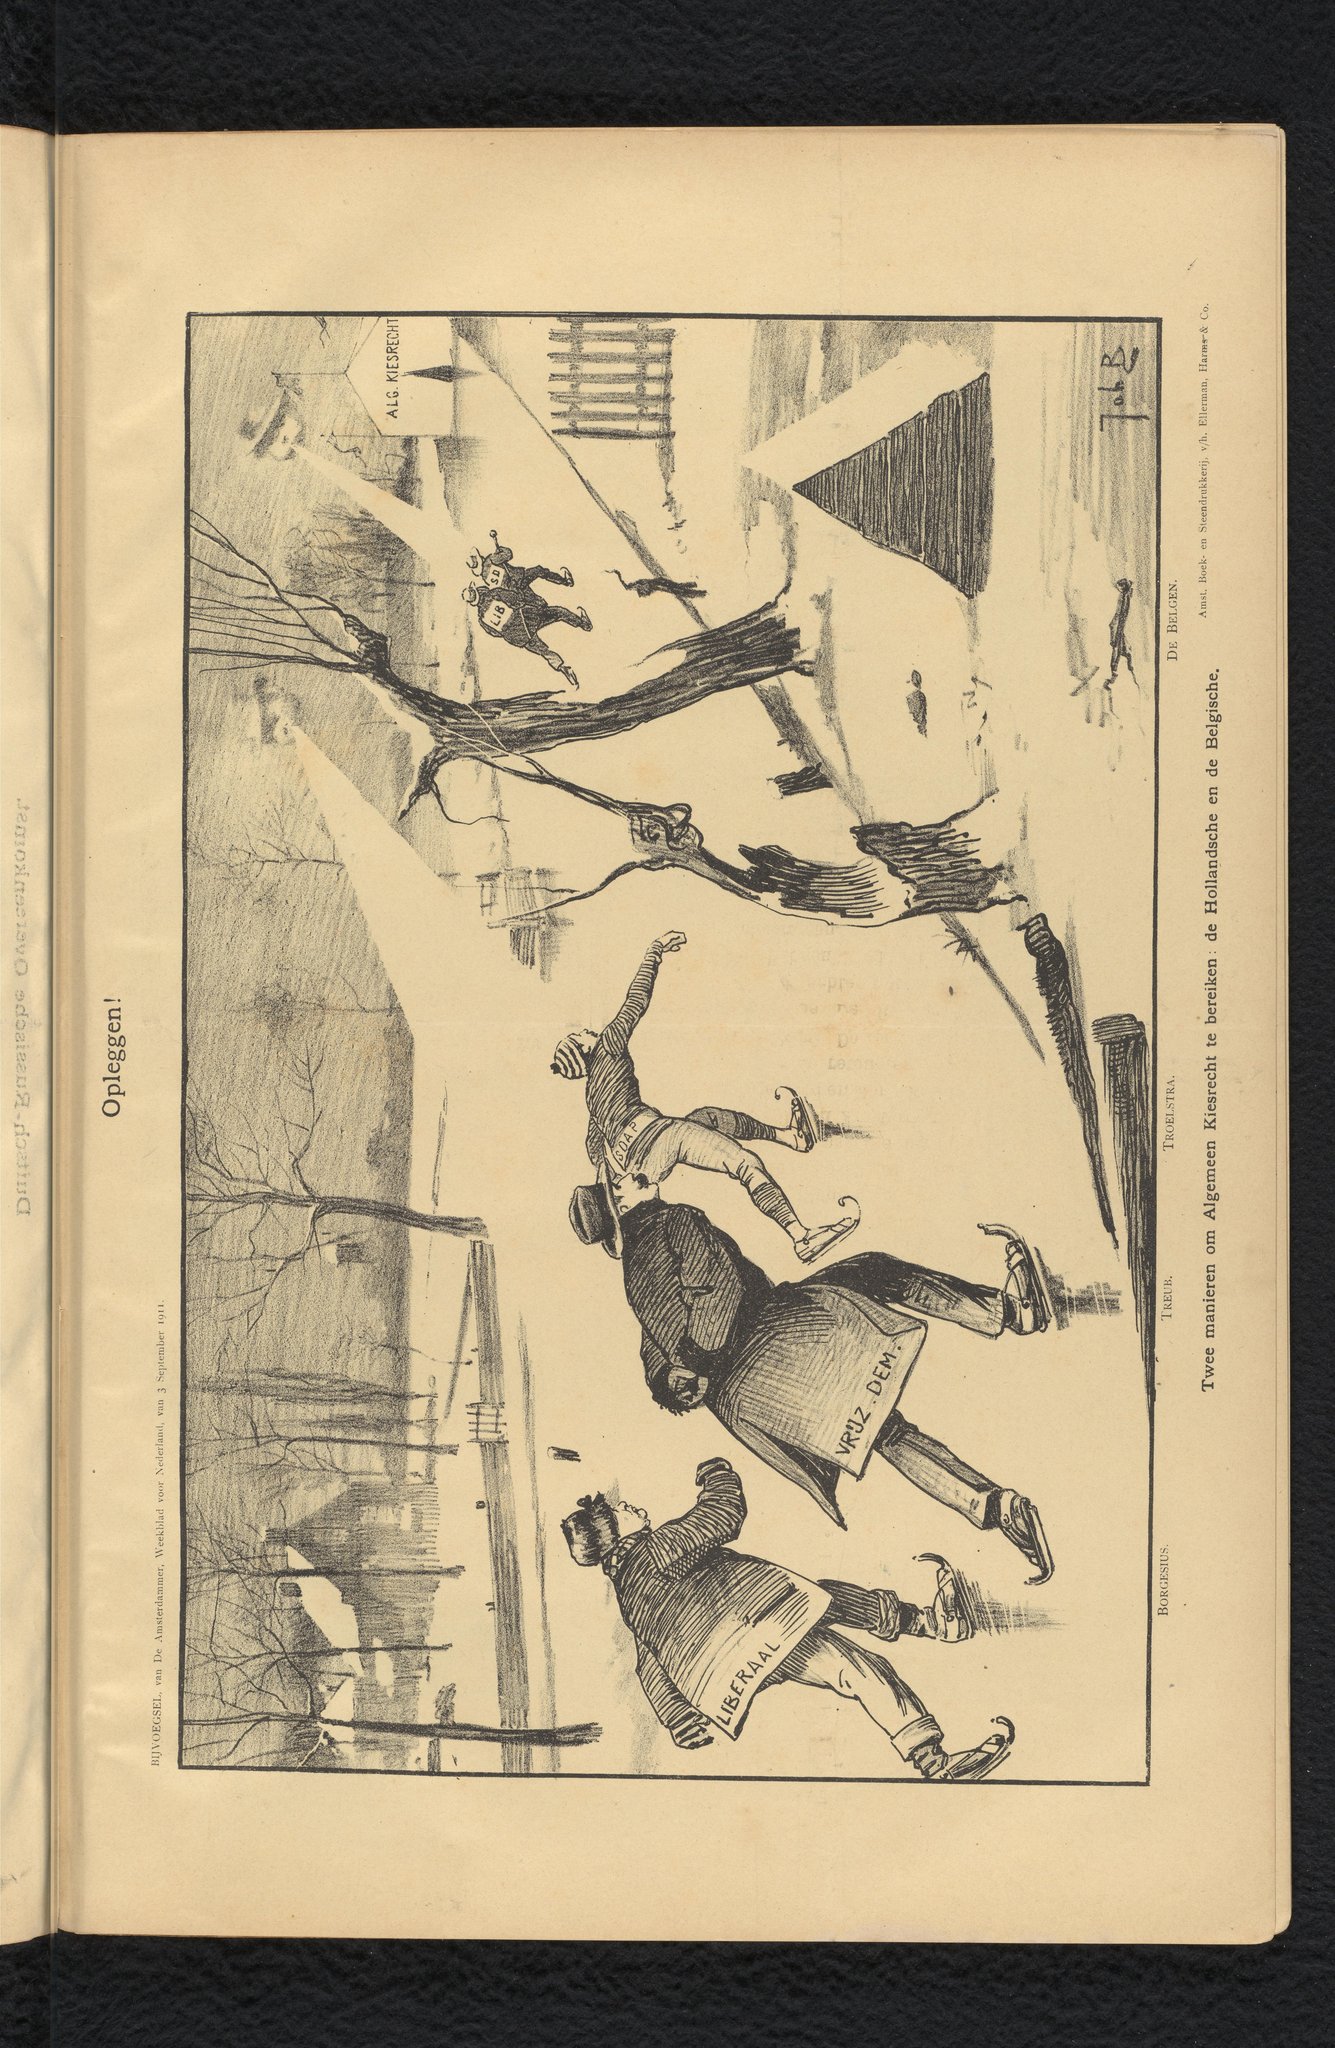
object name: cartoon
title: Opleggen!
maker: johan braakensiek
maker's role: draughtsman, print maker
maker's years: 1858-1940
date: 1911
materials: paper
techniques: lithograph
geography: netherlands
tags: the hague, politician, voorschoten, the right to vote, the compulsory vote, skates (winter sports), political caricatures and satires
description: De pogingen om algemeen kiesrecht te bereiken in Nederland en België voorgesteld als een schaatswedstrijd. De Belgische politieke partijen werken goed samen en rijden voorop maar onder de Nederlanders, Treub, Troelstra en Borgesius, is geen samenwerking.